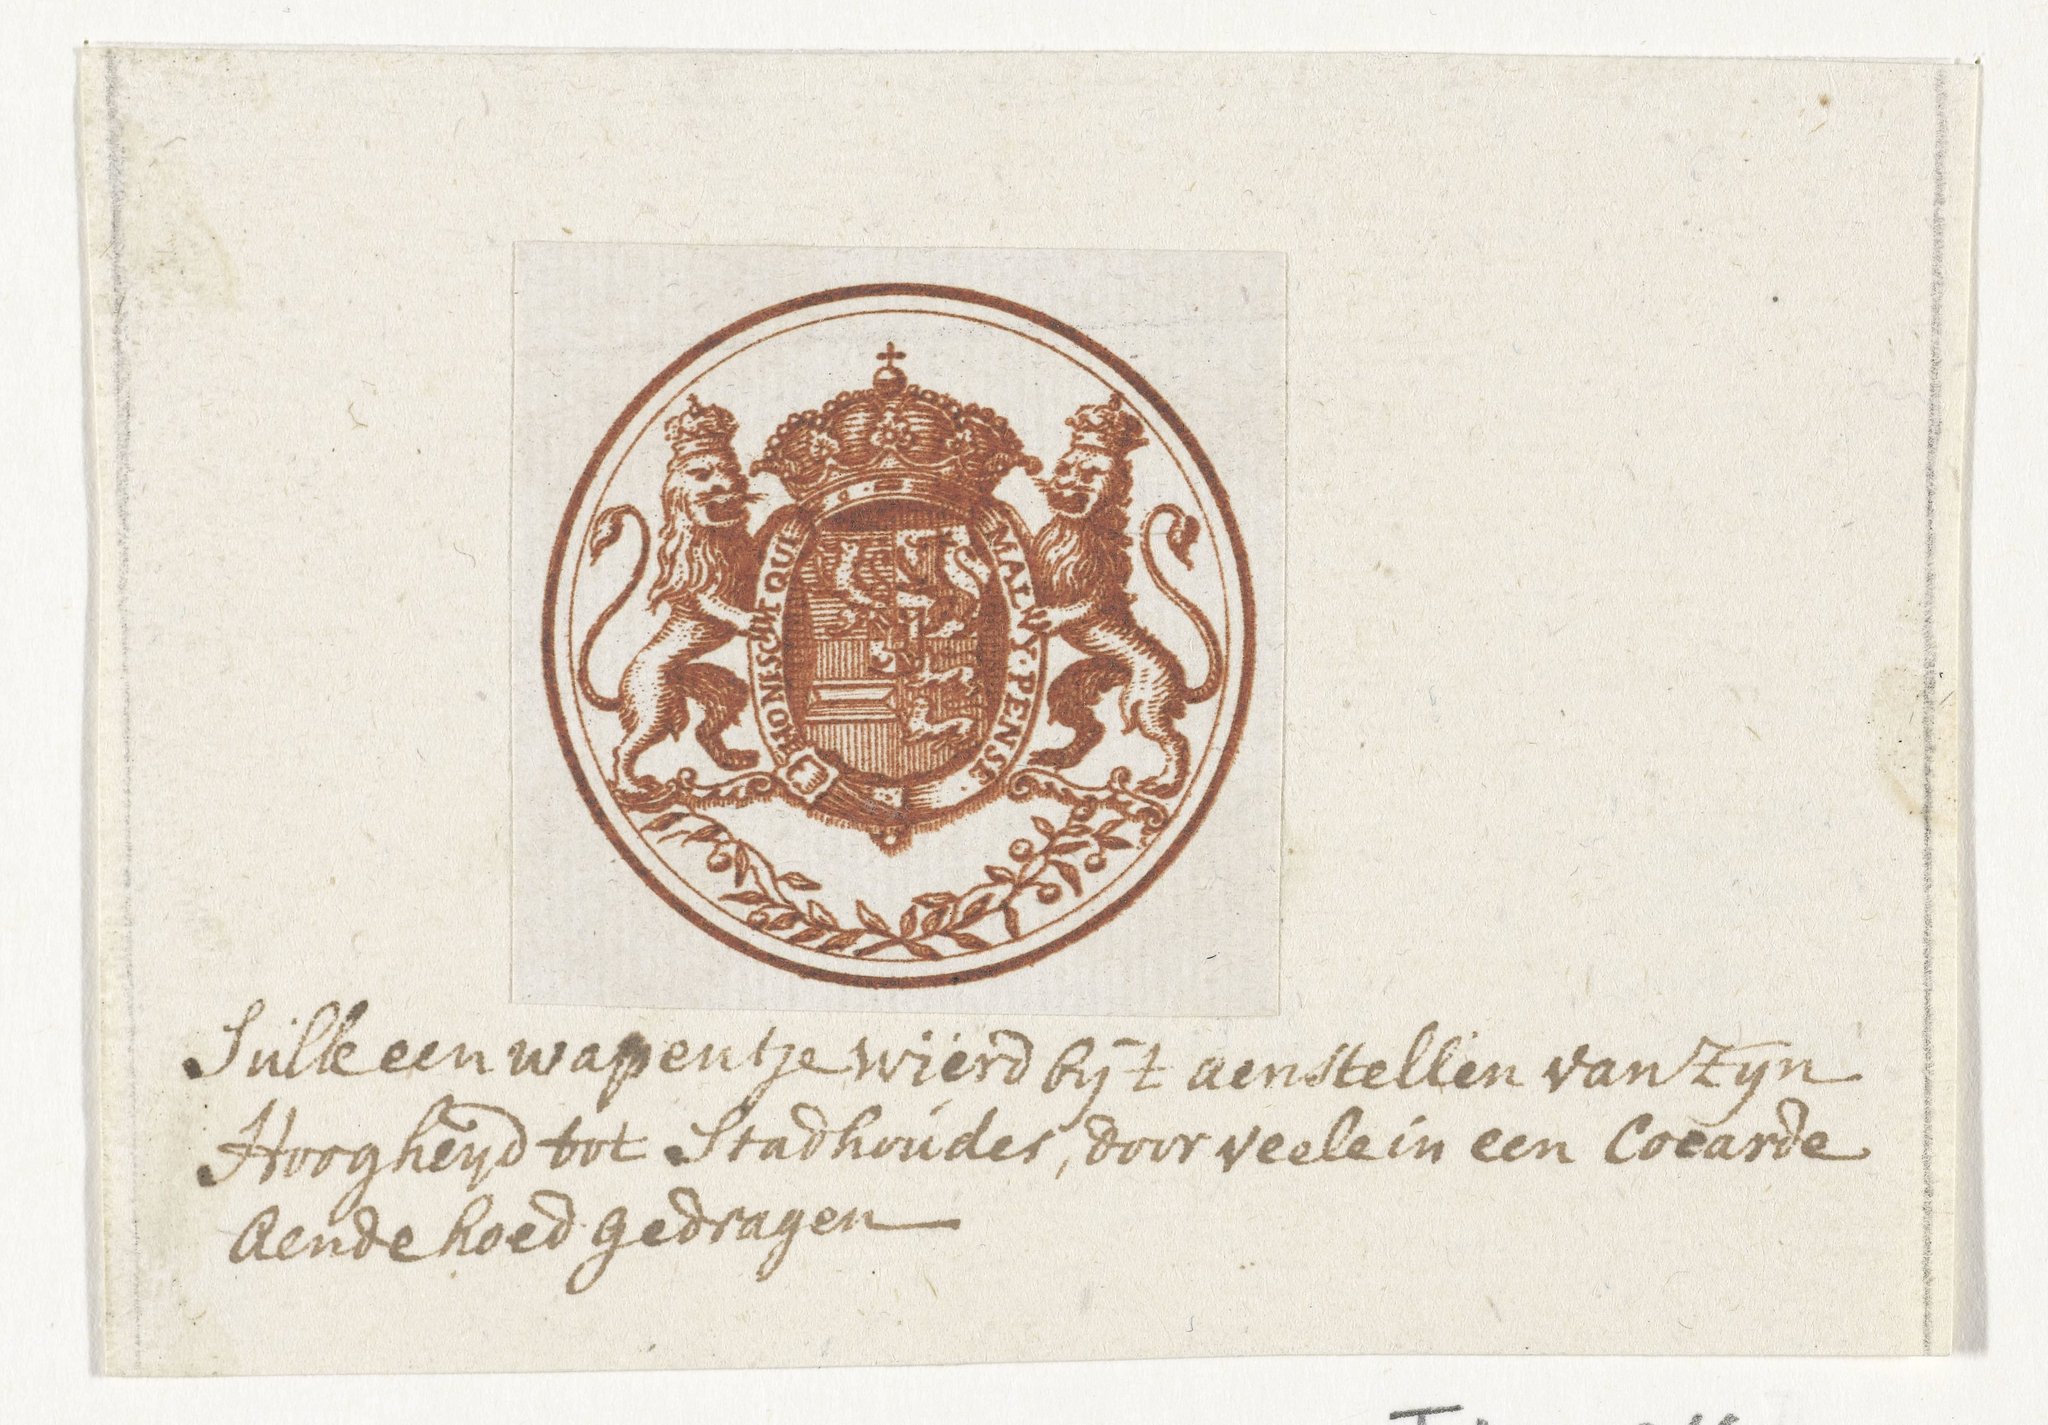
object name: print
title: Wapen van Engeland, gedragen bij de verkiezing van Willem IV tot stadhouder, 1747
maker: Anonymous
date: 1747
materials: paper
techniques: etching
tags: the hague, willem iv (prins van oranje-nassau), insignia and symbols of sovereignty (crown, diadem, sceptre, orb, seal, standard, cloak, pectoral), great britain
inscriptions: collector's mark: Lugt 2228, inscription: ‘Sulk een wapentje wierd by 't aenstellen van zyn Hoogheyd tot stadhouder, door veele in een cocarde aen de hoed gedragen’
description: Het wapen van Engeland, zoals het gedragen in een kokarde op de hoed bij de verkiezing van Willem IV tot stadhouder, mei 1747. Uitgeknipt en op een stuk papier geplakt met opschrift.